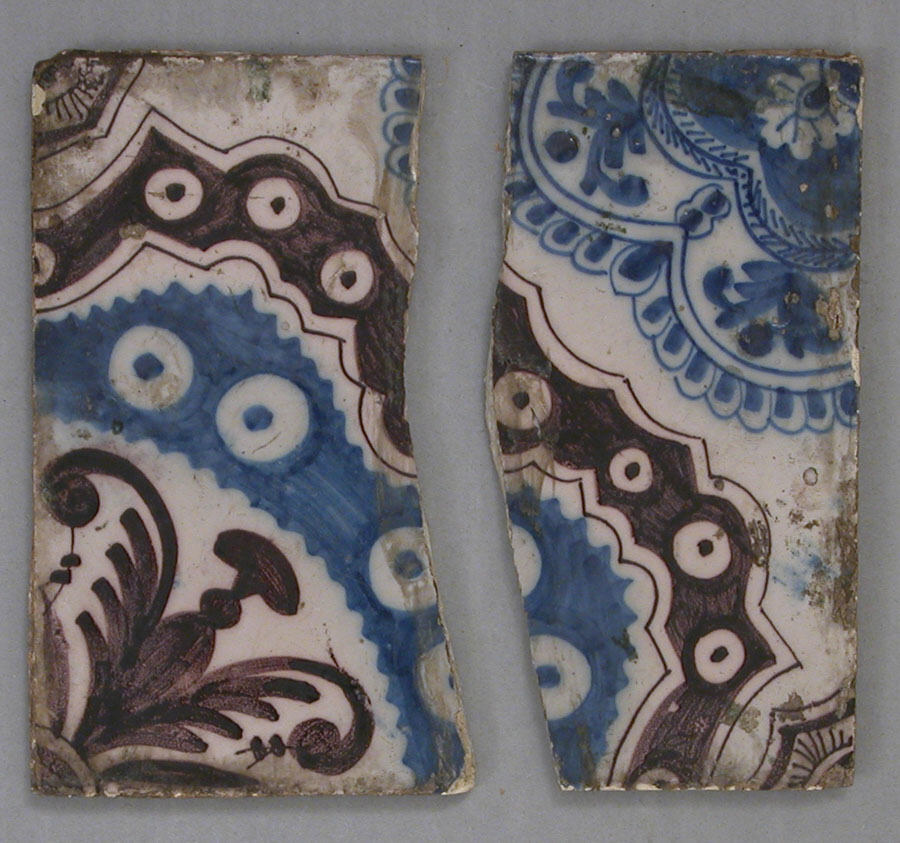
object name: tile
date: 1701-1800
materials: stonepaste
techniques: glazing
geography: north africa